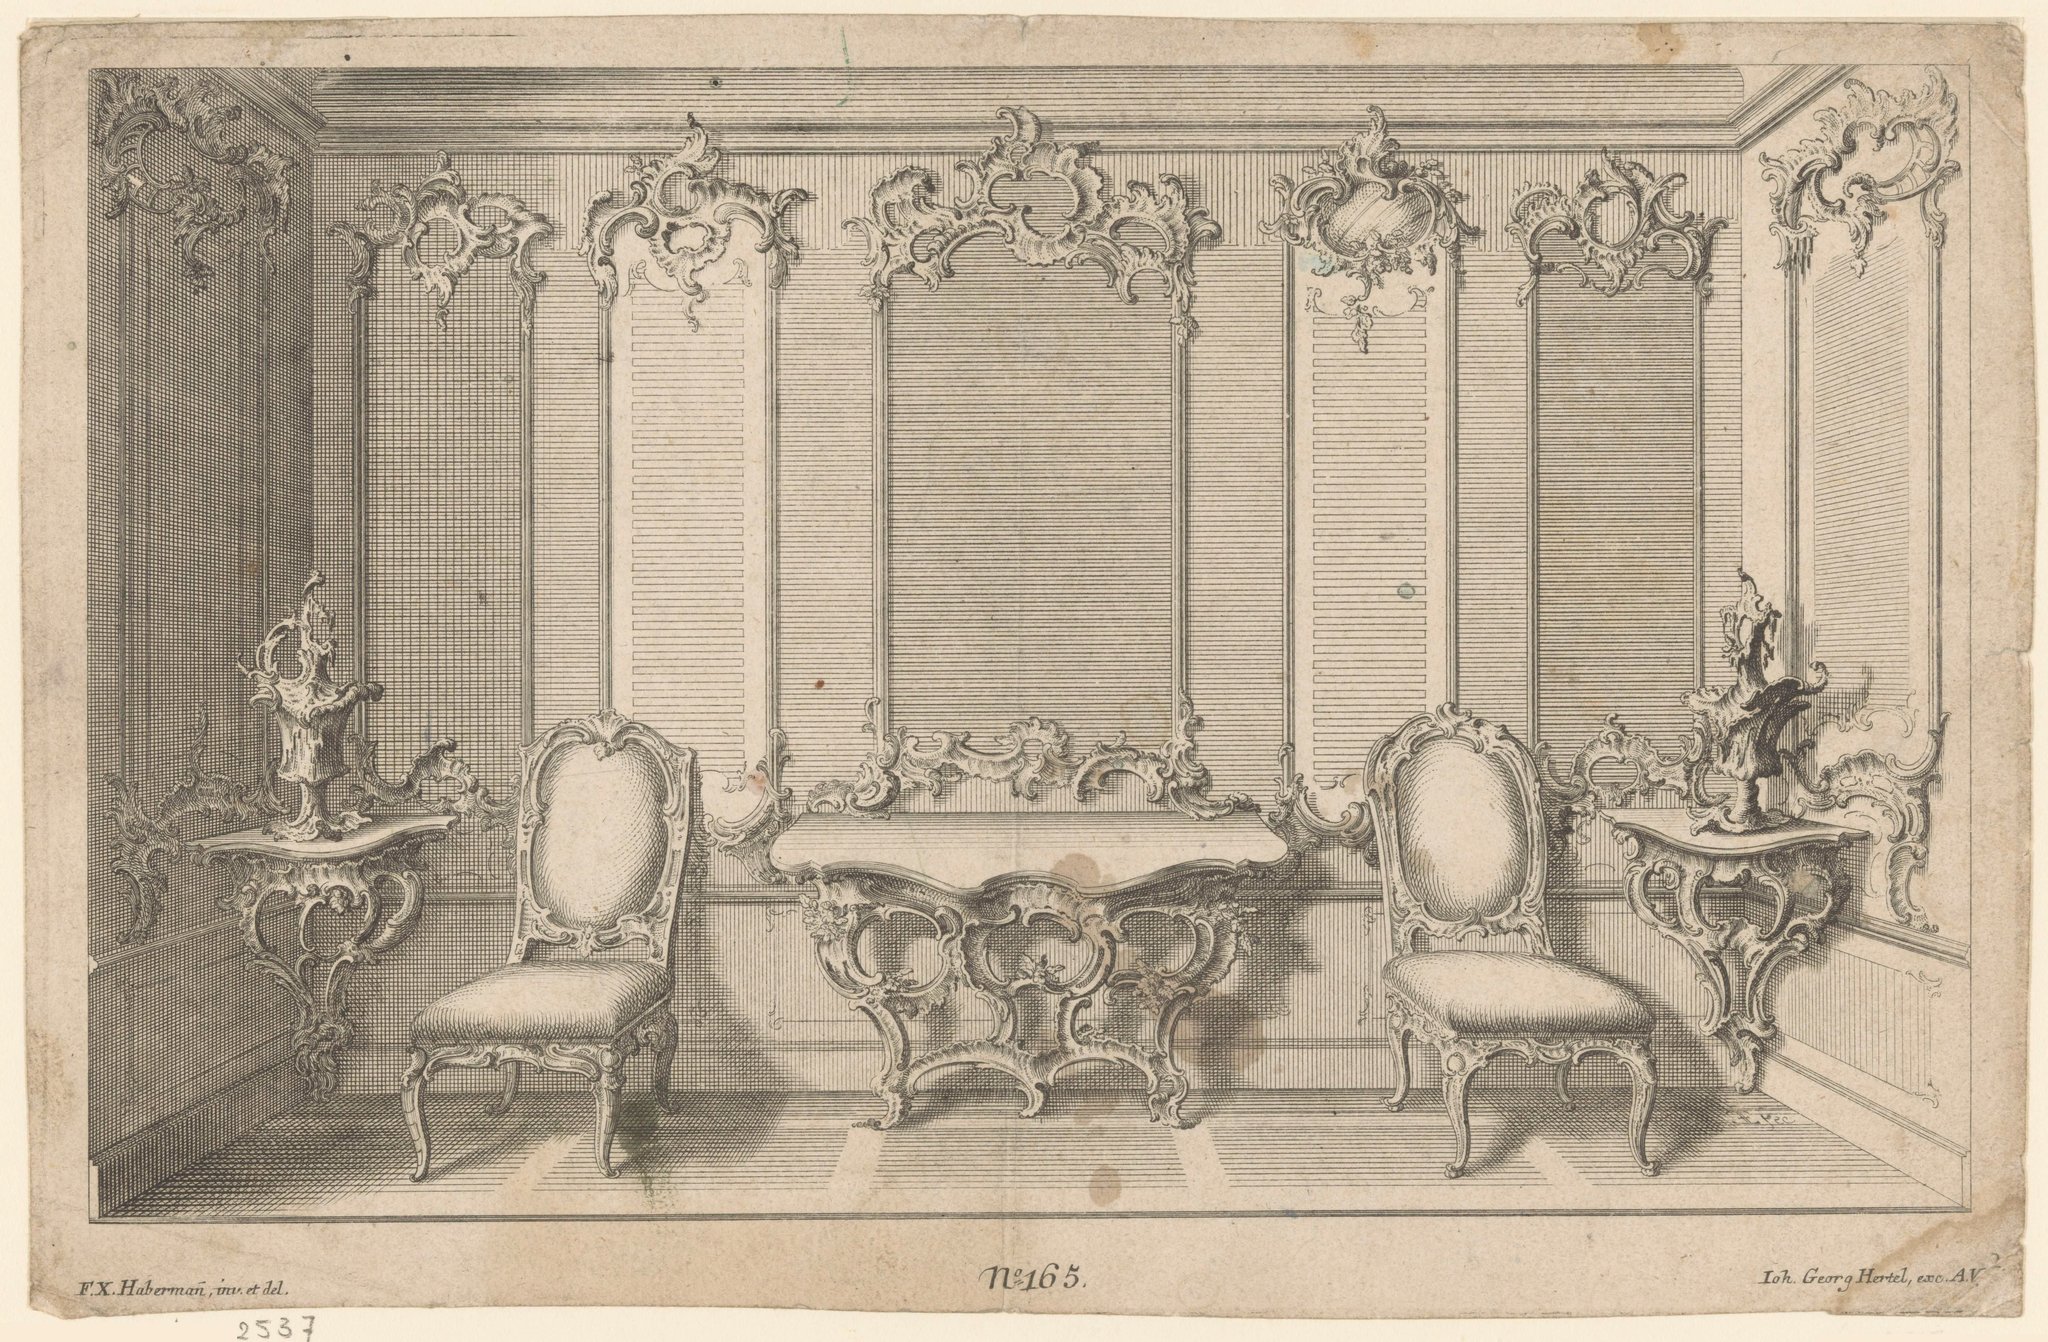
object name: print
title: Interieur met tafels en stoelen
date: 1731-1775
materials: paper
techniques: engraving, etching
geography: augsburg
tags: rocaille ornament, interior of the house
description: Interieur met panelen, een tafel, twee stoelen en twee hoektafels met vazen. Alles met rocaille ornamenten gedecoreerd. Uitgeversnummer 165.